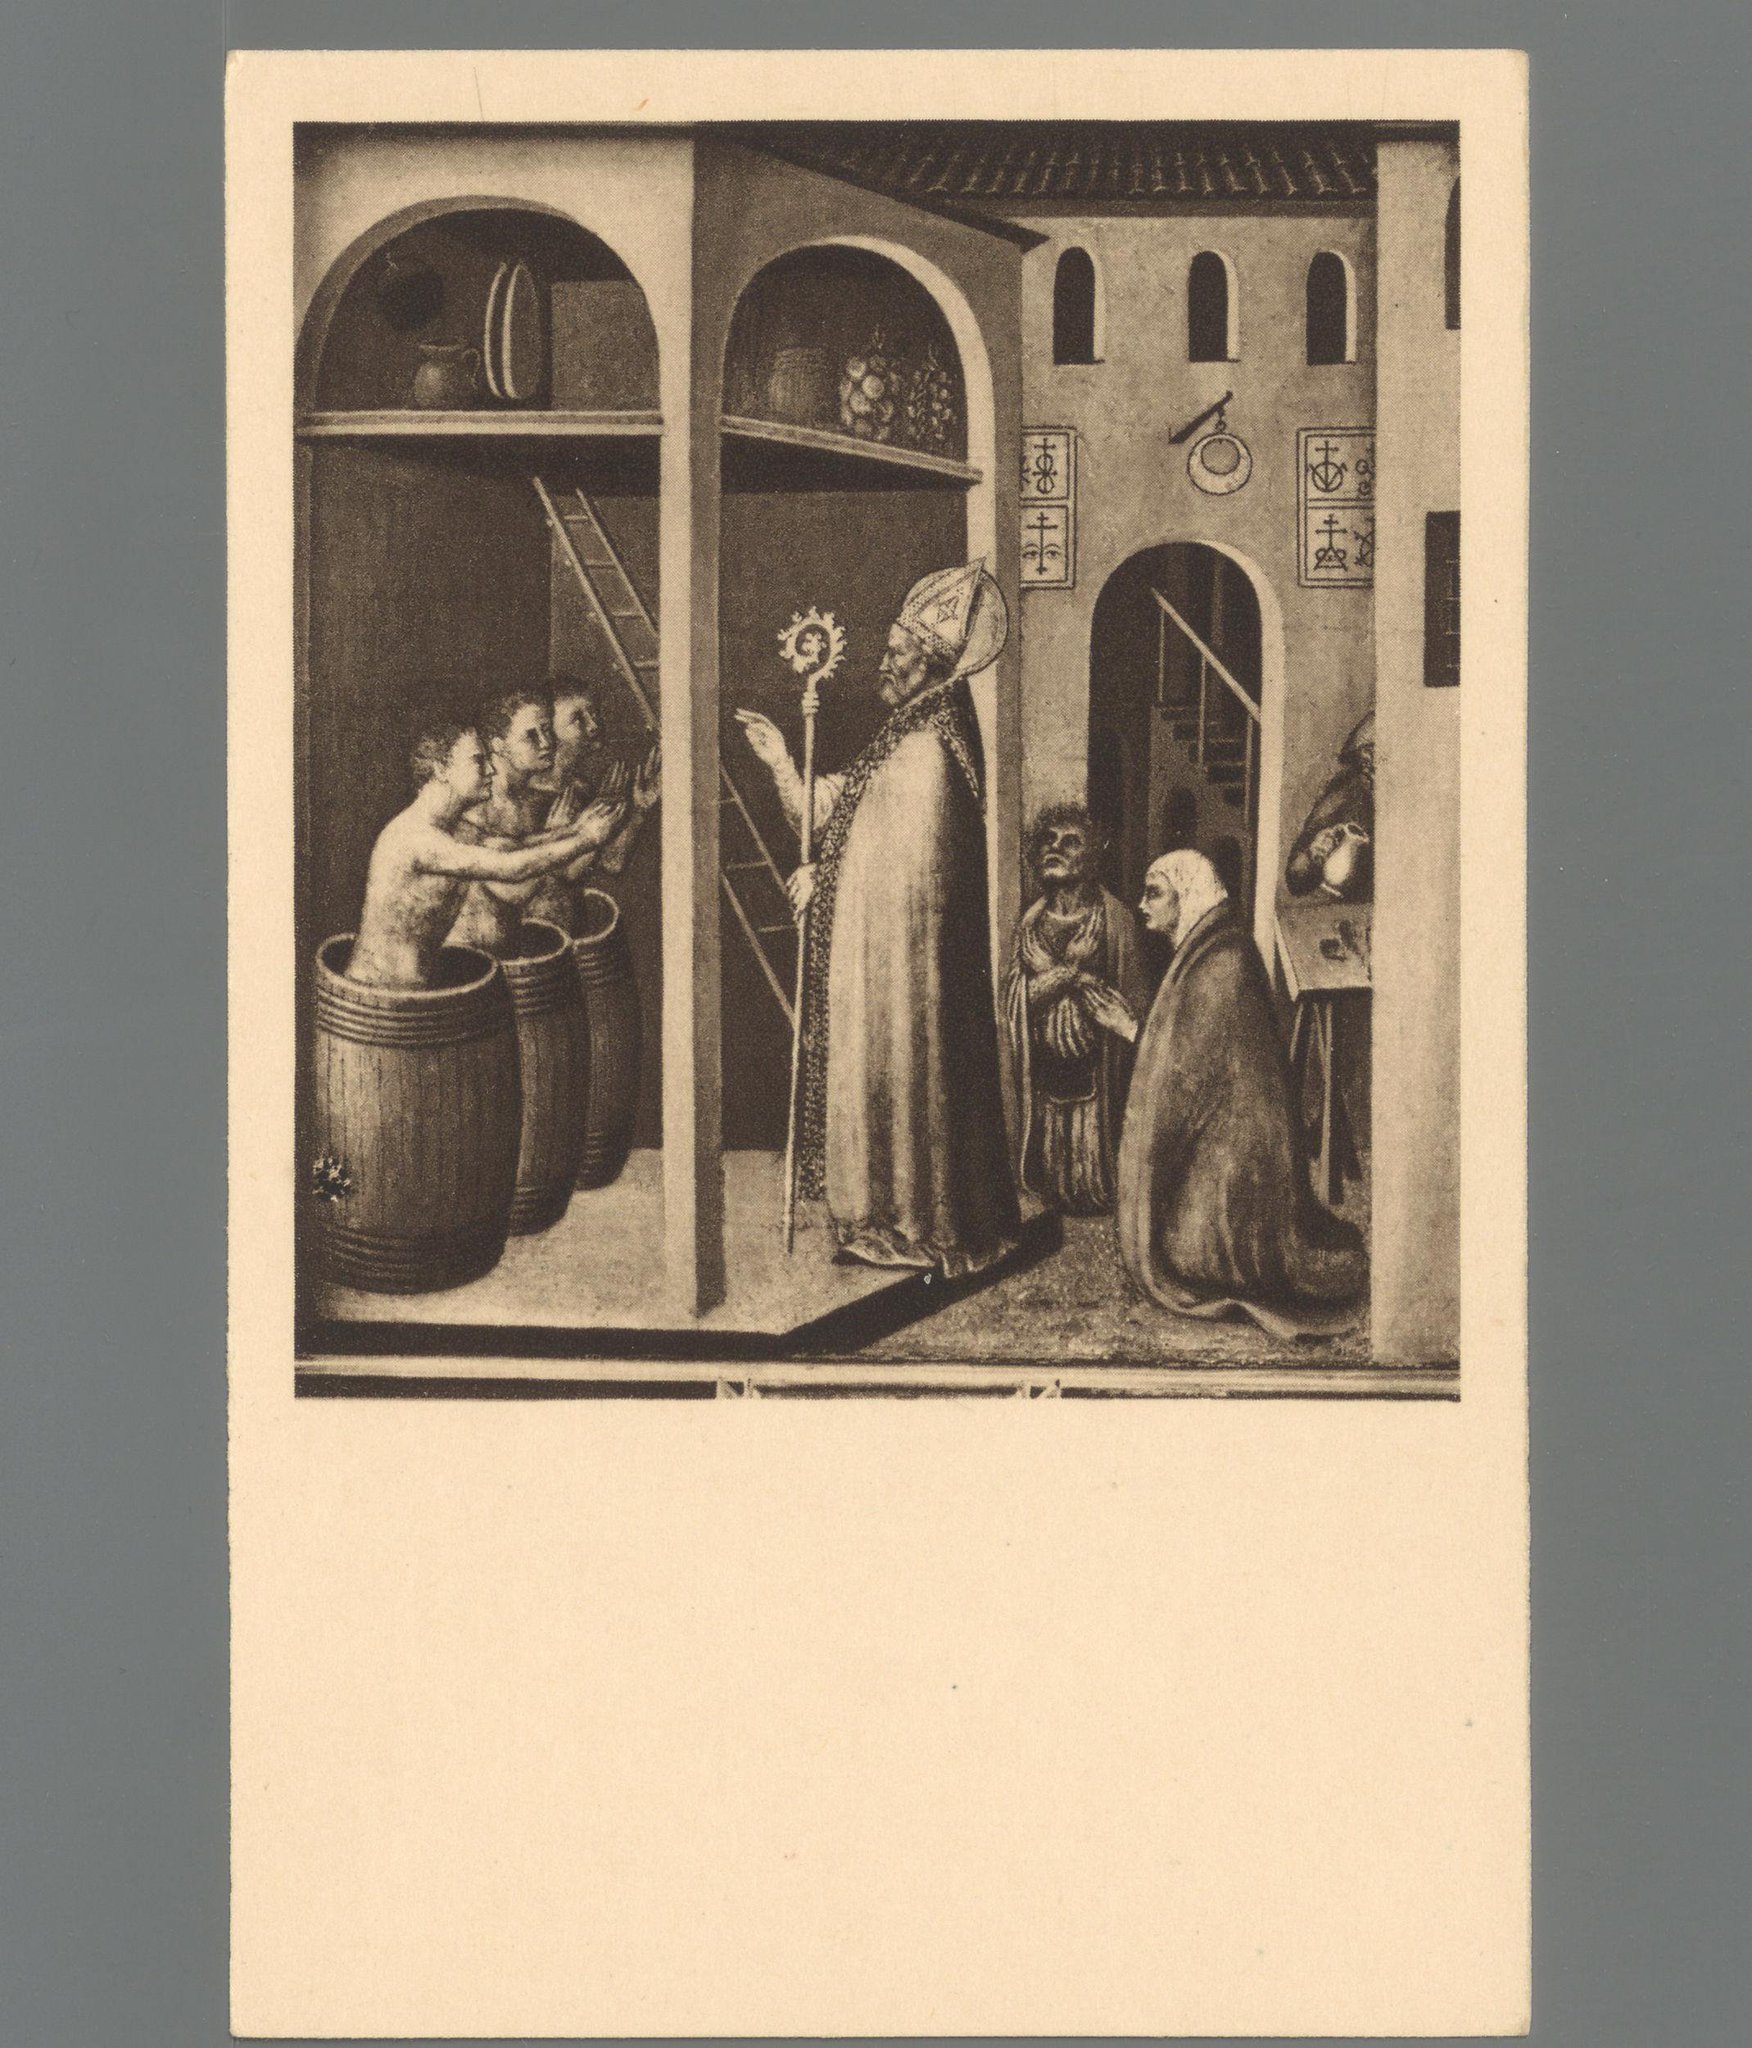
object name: reproduction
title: School van Gentile da Fabriano (eerste helft der 15de eeuw). De H. Nicolaas schenkt het leven terug aan drie vermoorde knapen - Rome, Pinacoteca Vaticana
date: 1928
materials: cardboard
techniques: rotogravure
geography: milan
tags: permanent exhibition, museum, picture, painting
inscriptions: collector's mark: ‘AFE v S’